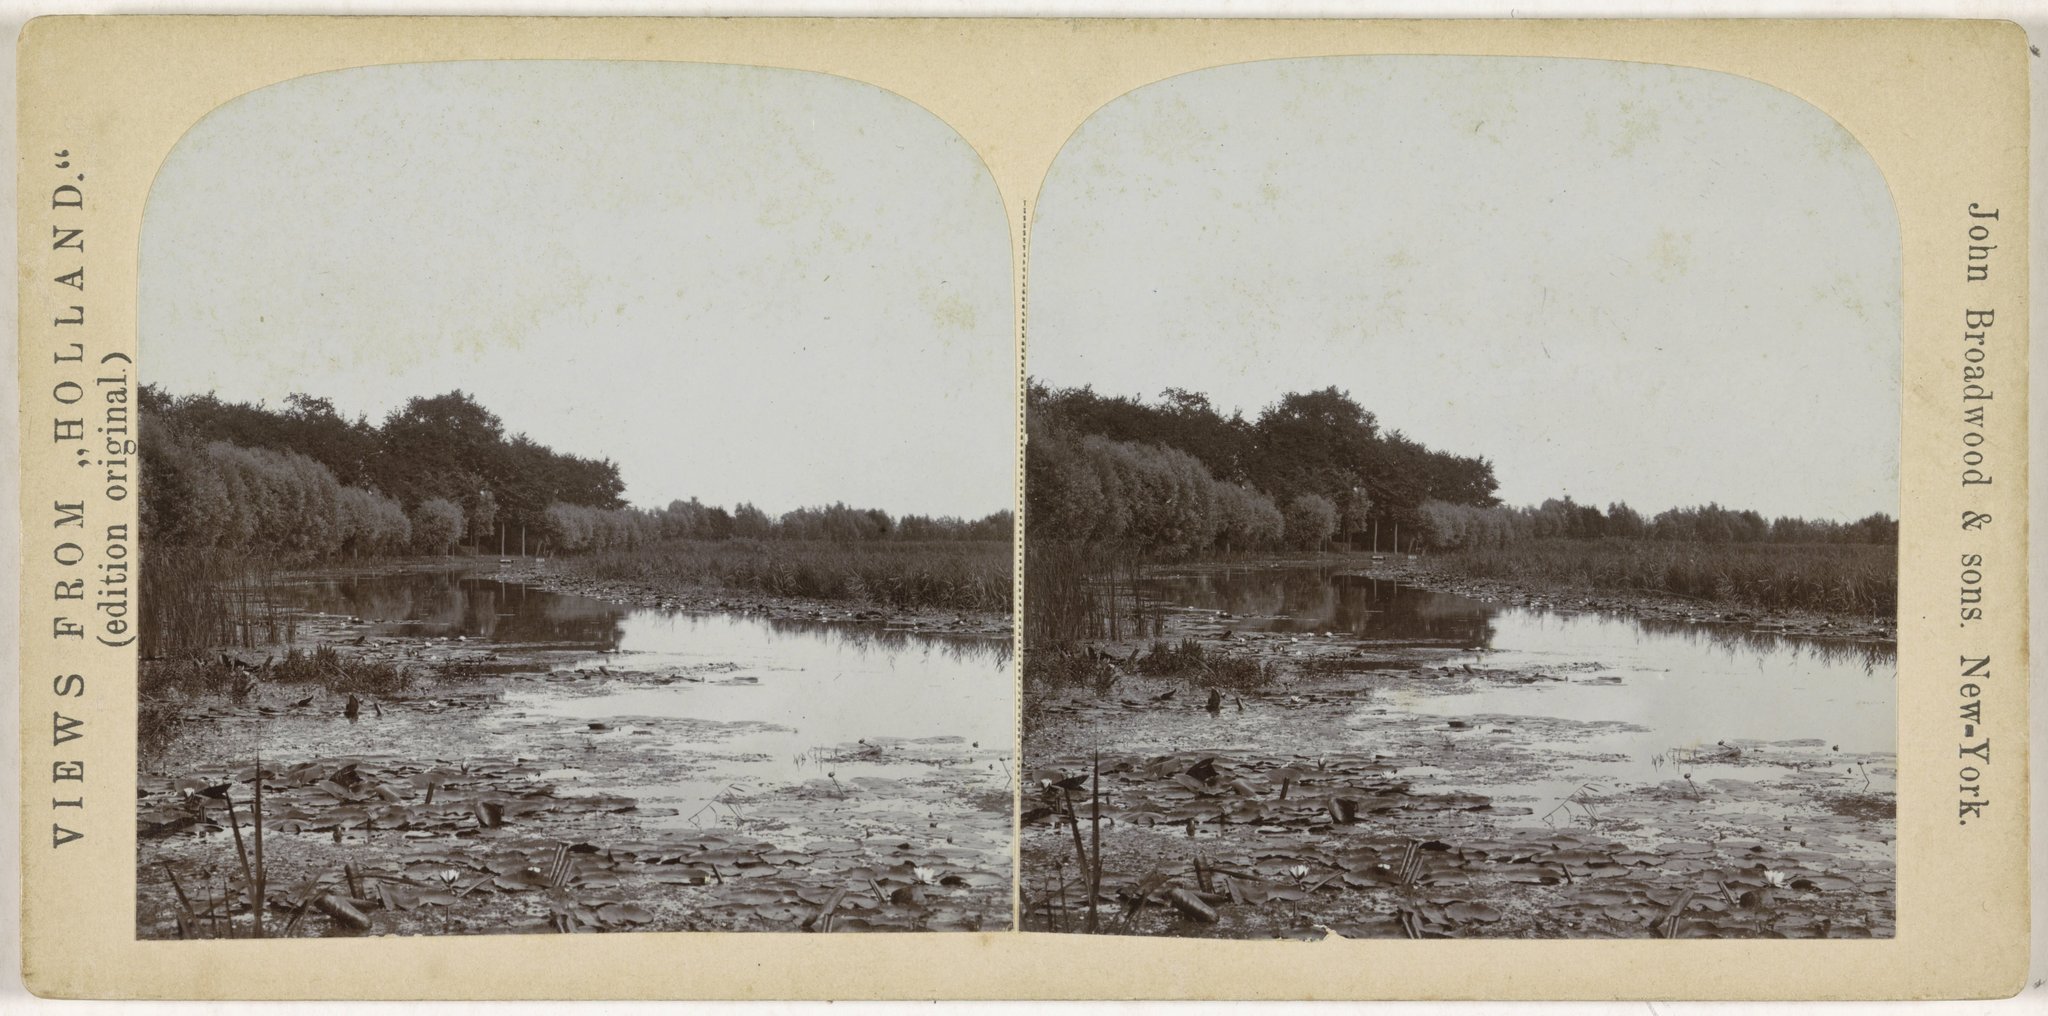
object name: stereograph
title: Gezicht op rivier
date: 1880-1920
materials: cardboard, paper, photographic support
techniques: gelatin silver print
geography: new york city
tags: netherlands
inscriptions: inscription: ‘VIEWS FROM ''HOLLAND.'' (edition original.)’, number: ‘25’